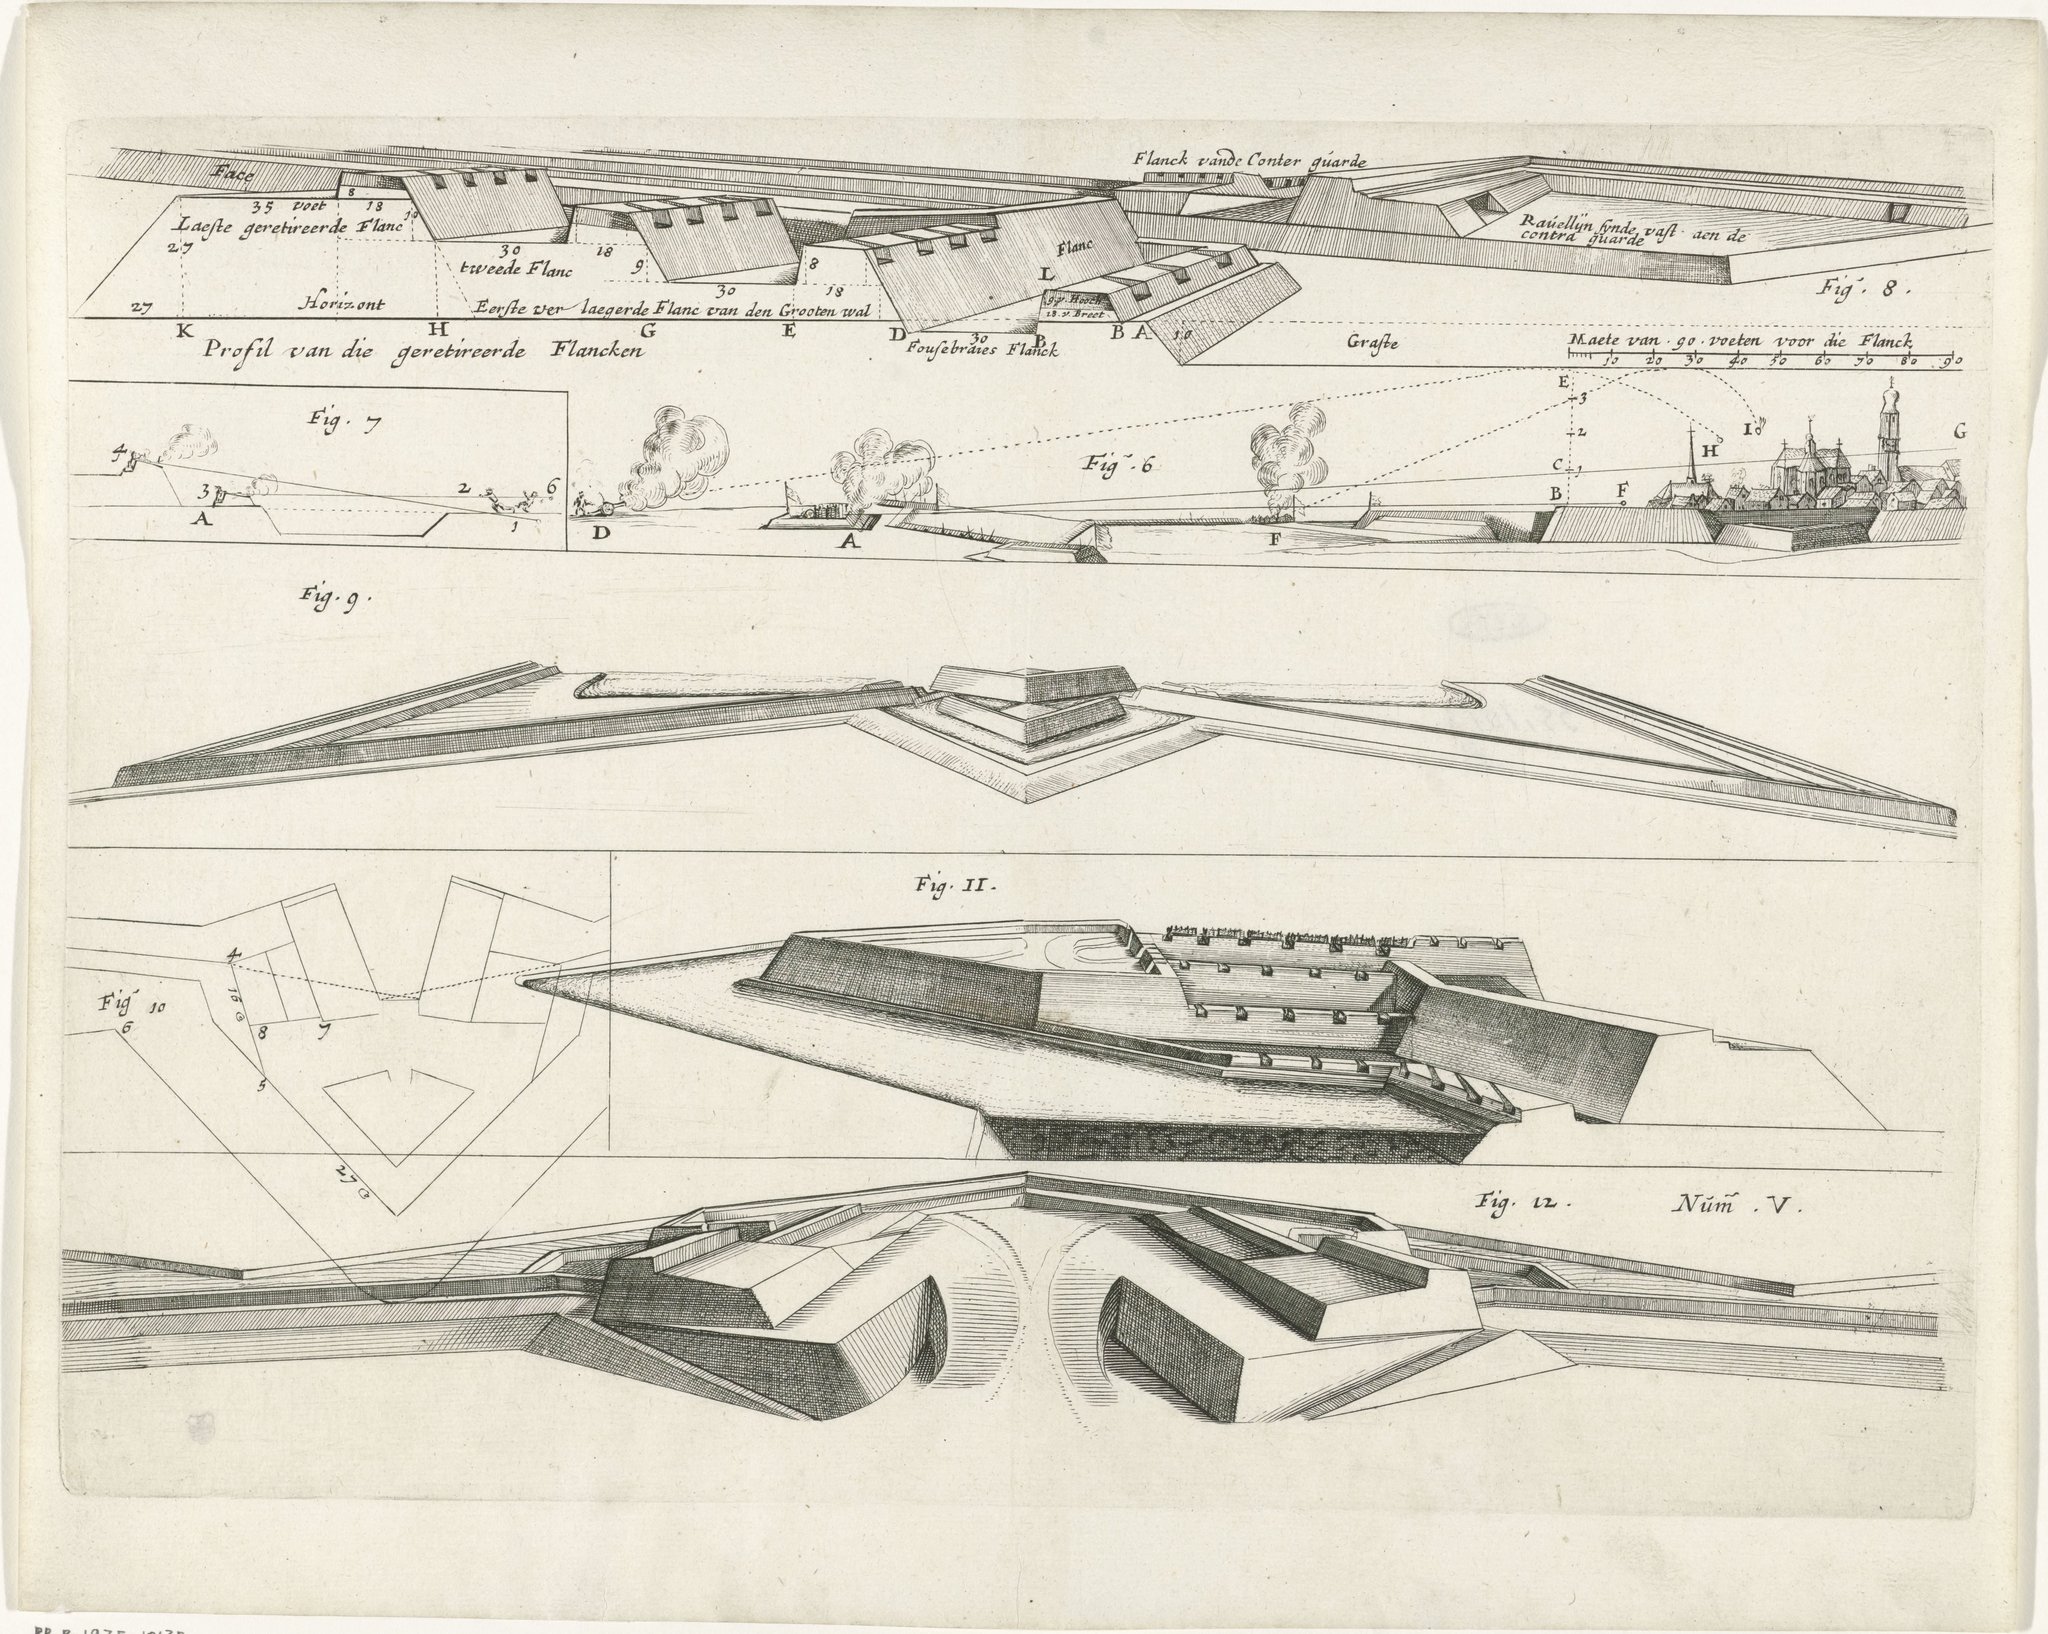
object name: print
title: Technische tekeningen van een versterkte vestingwal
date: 1654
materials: paper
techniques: engraving, etching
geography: amsterdam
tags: drawing (industrial process) (+ technical aspects ~ crafts, industries, agriculture), fortifications, military engineering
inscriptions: collector's mark: Lugt 2760, collector's mark: Lugt 2228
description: Illustratie voor: Henrich Ruse. Versterckte Vesting. Amsterdam: Johannes Willemszoon Blaeu, 1654.